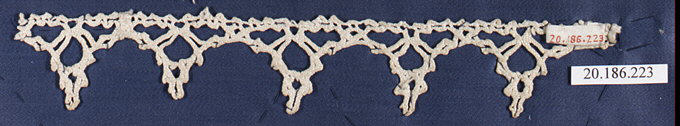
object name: edging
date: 1501-1600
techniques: lace